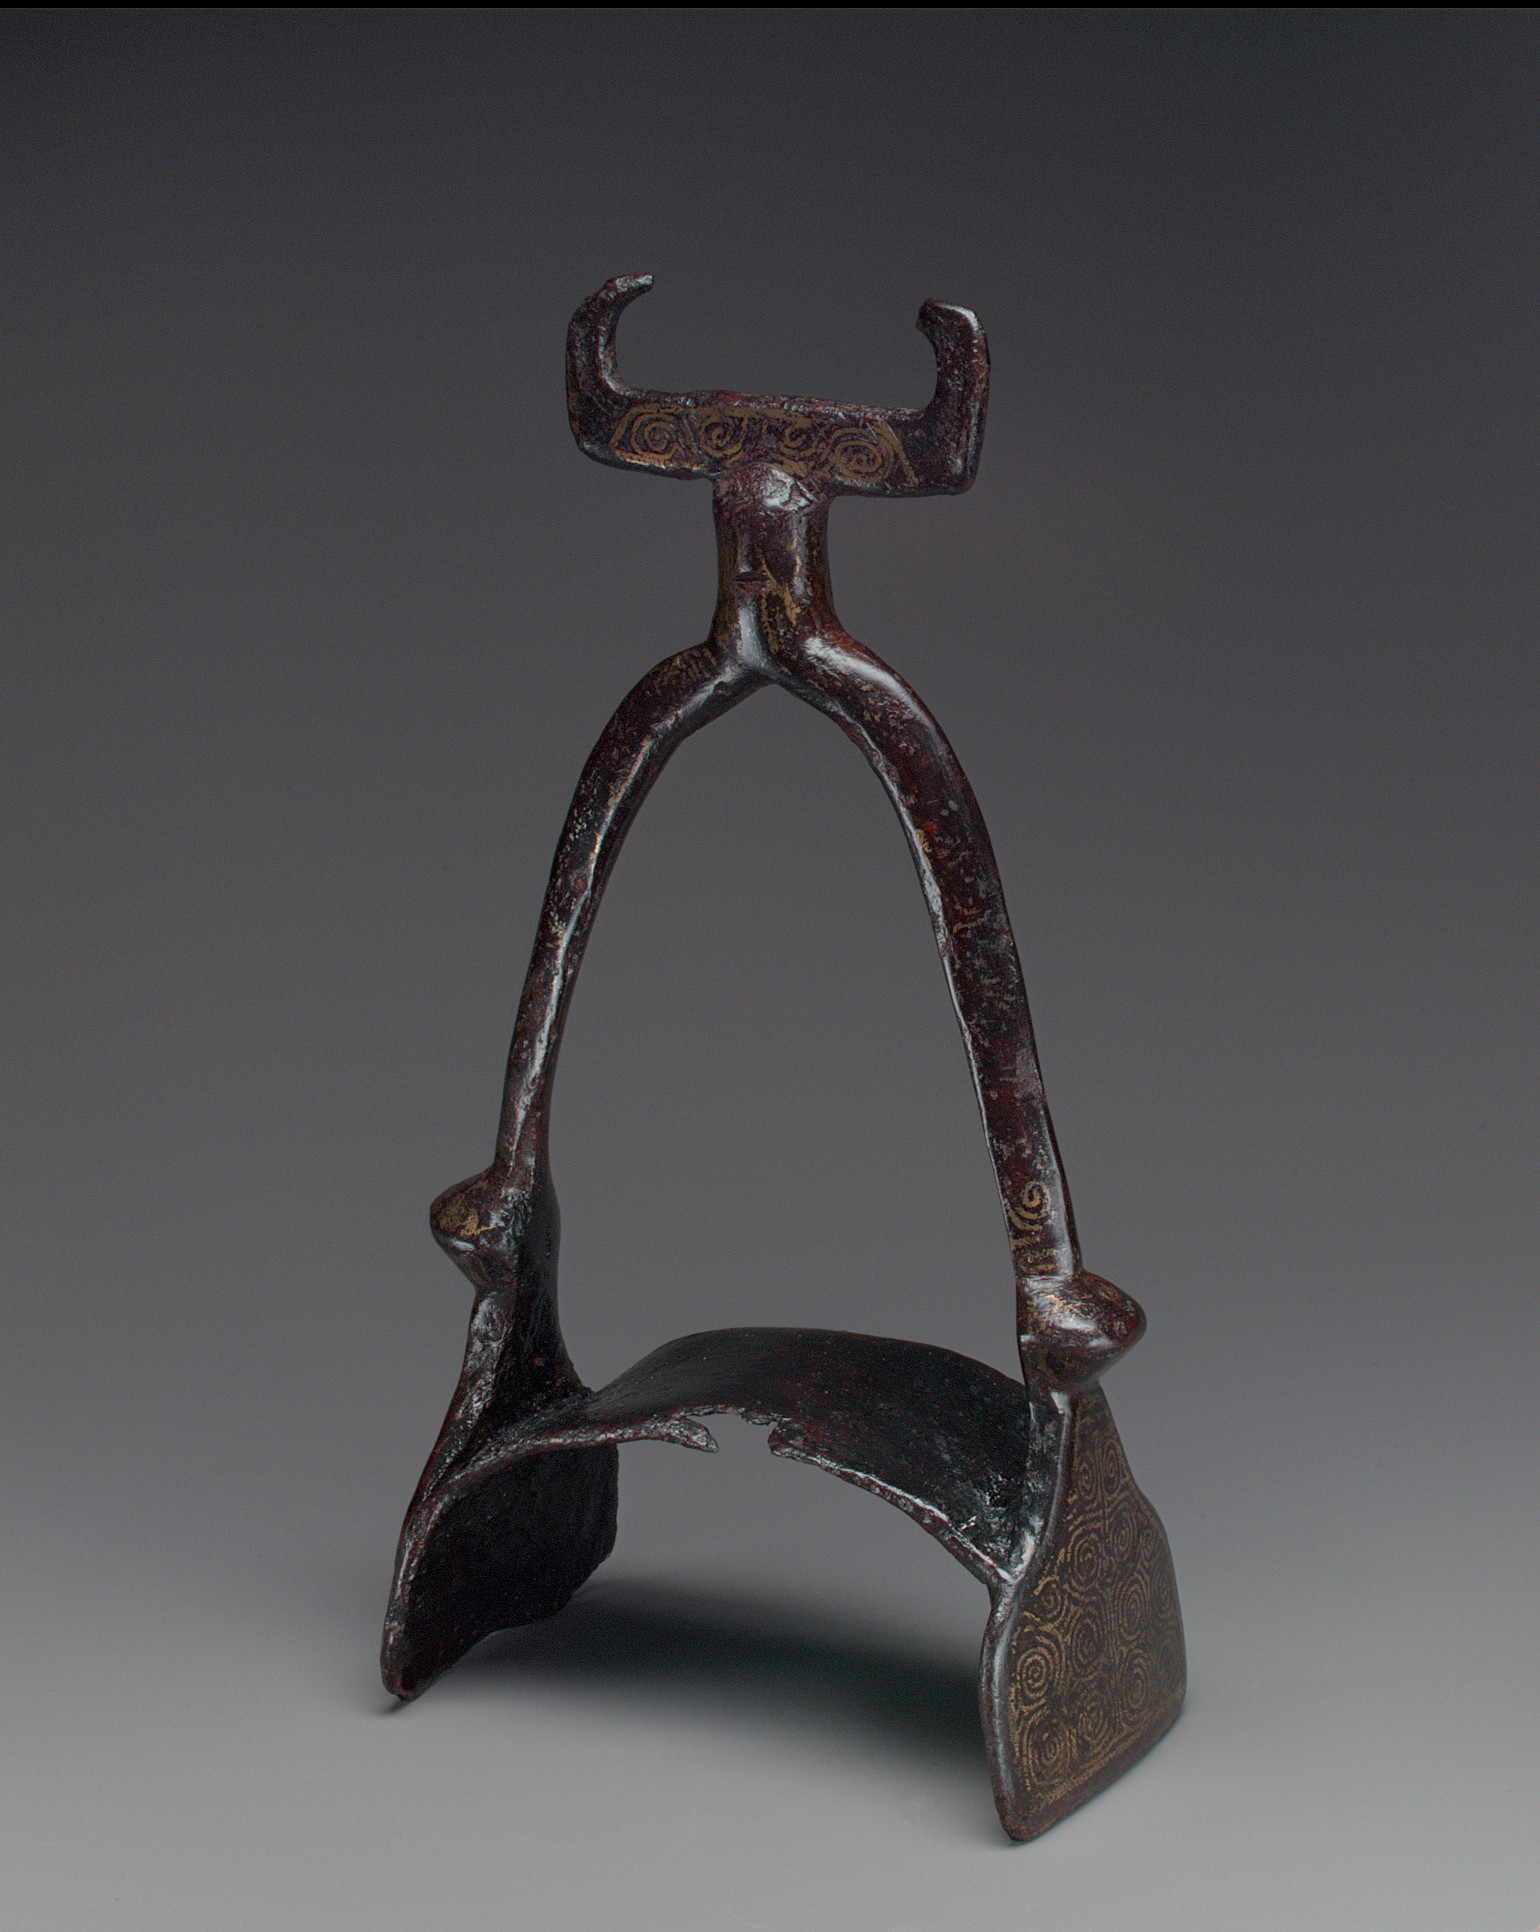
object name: stirrup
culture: anglo-scandinavian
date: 975-1075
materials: copper alloy, iron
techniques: inlay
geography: england